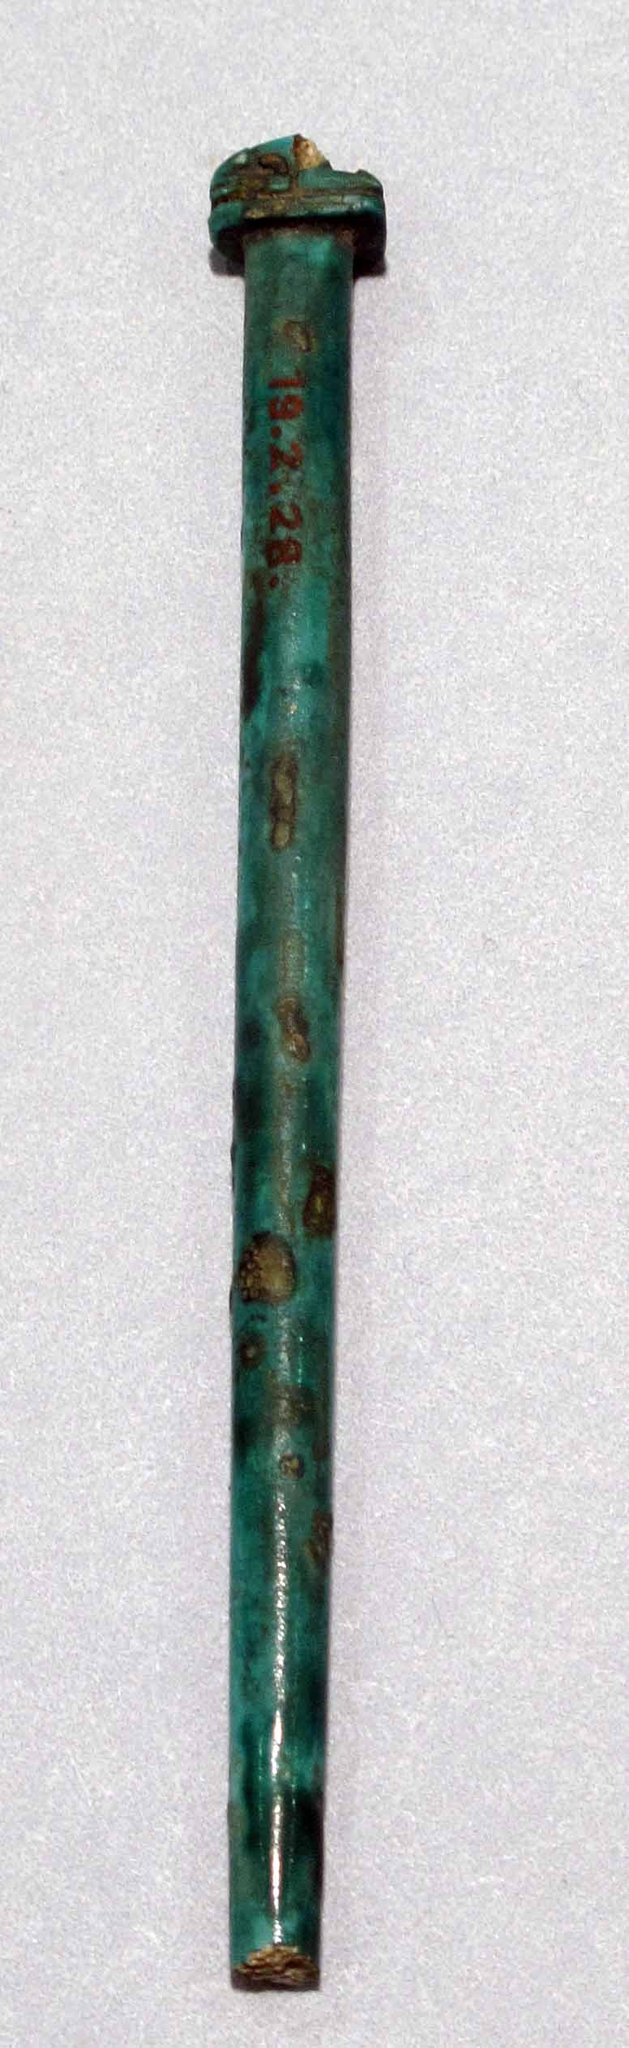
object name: cosmetic tool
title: Cosmetic tool (?)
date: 1550-1295 BCE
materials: stone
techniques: glazing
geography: egypt